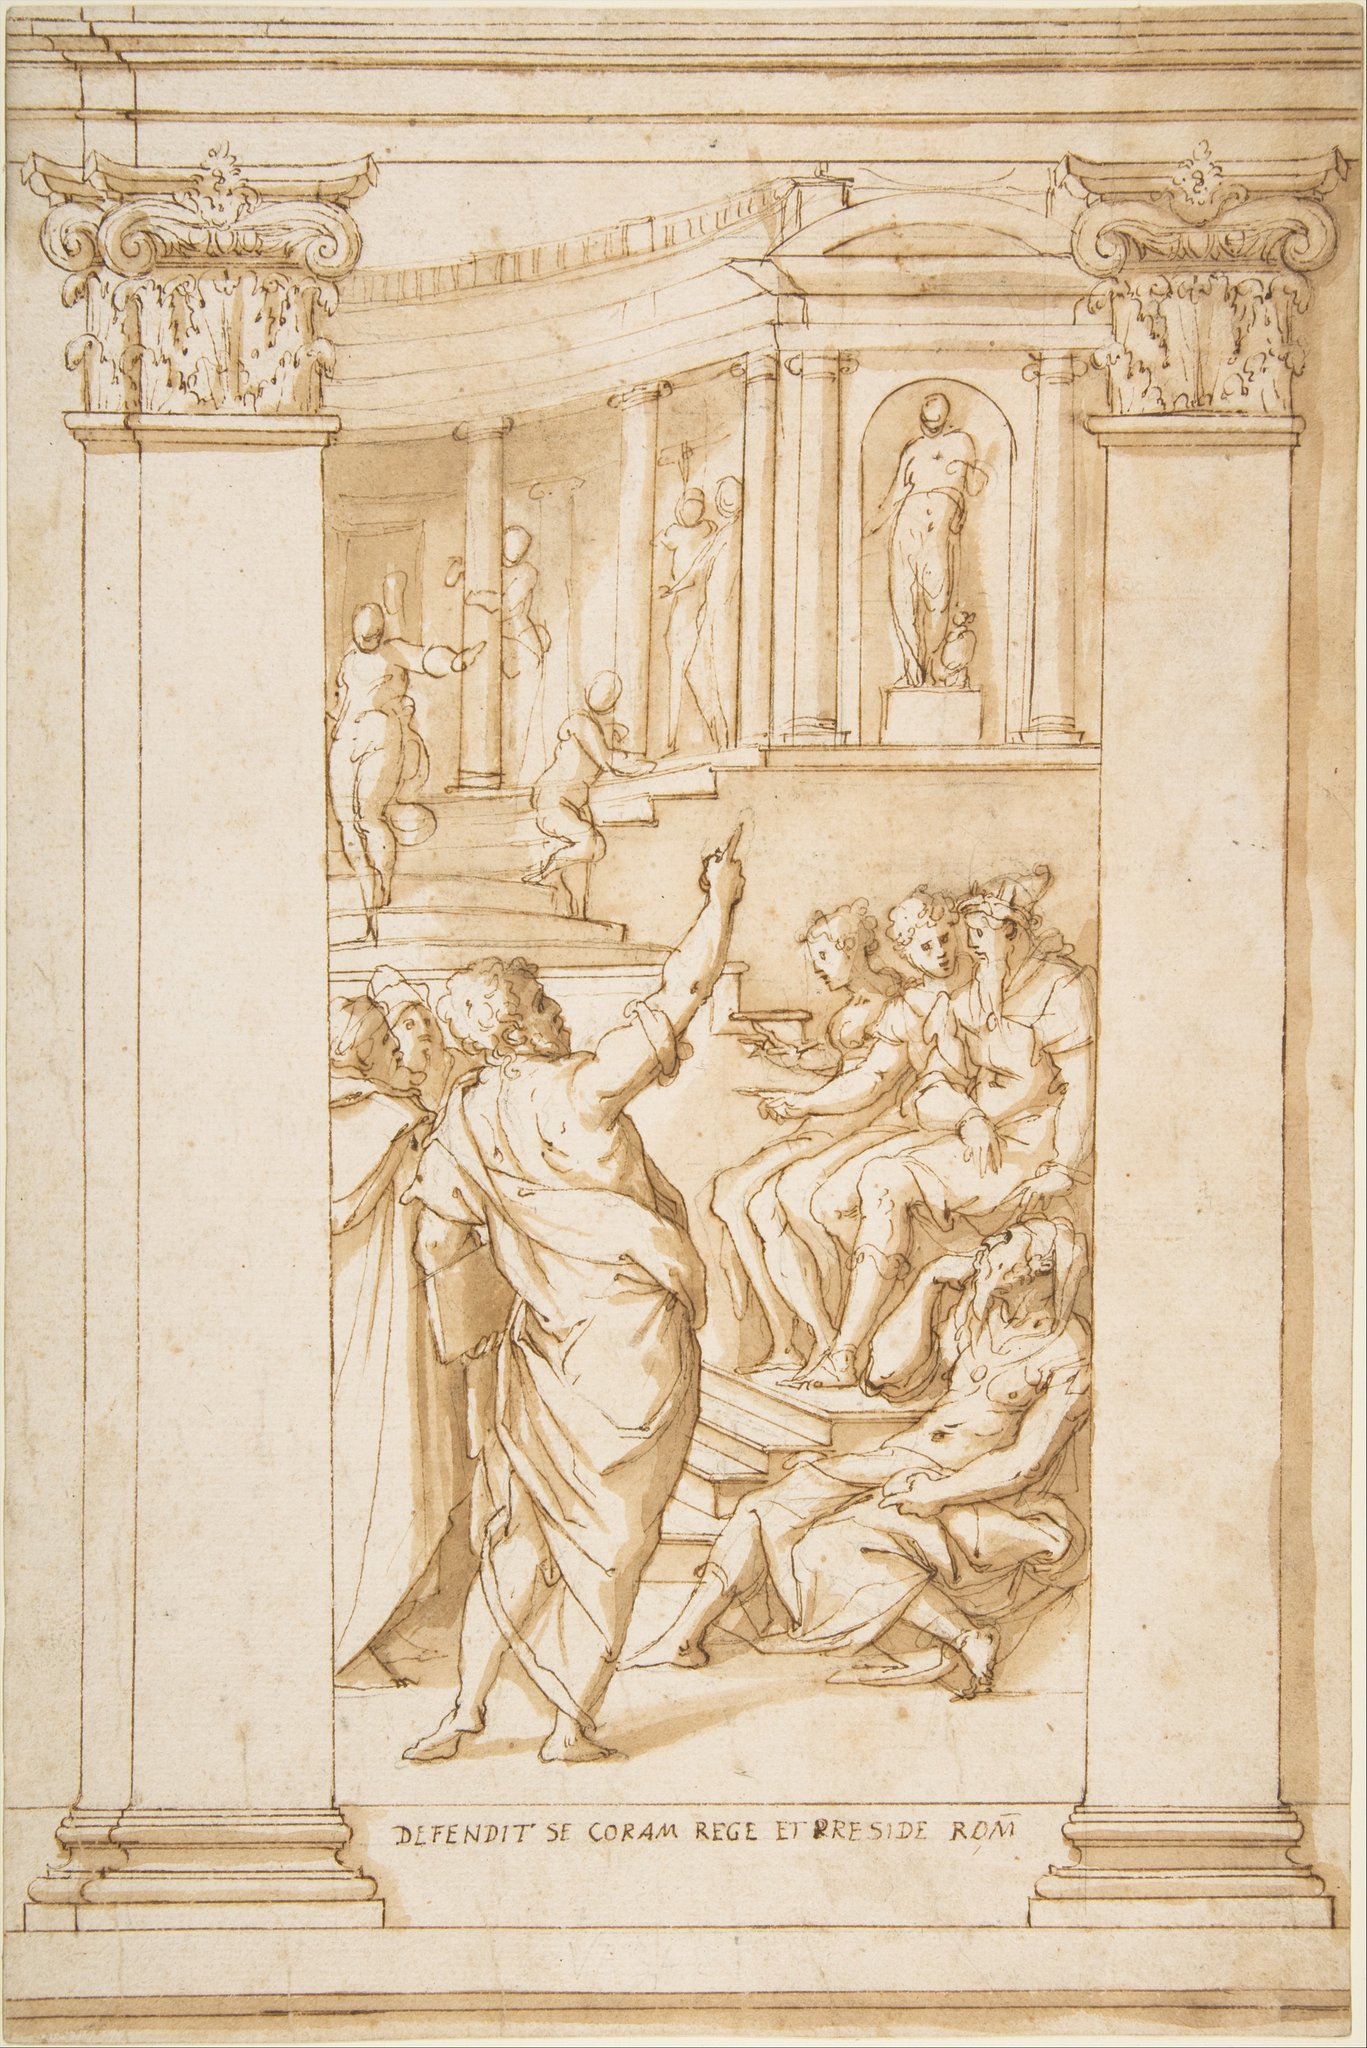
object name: drawing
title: Saint Paul Speaking before King Agrippa (Acts 26)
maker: giorgio vasari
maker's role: artist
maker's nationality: italian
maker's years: 1511-1574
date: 1573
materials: chalk, ink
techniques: brush, pen, wash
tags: kings,men,saint paul